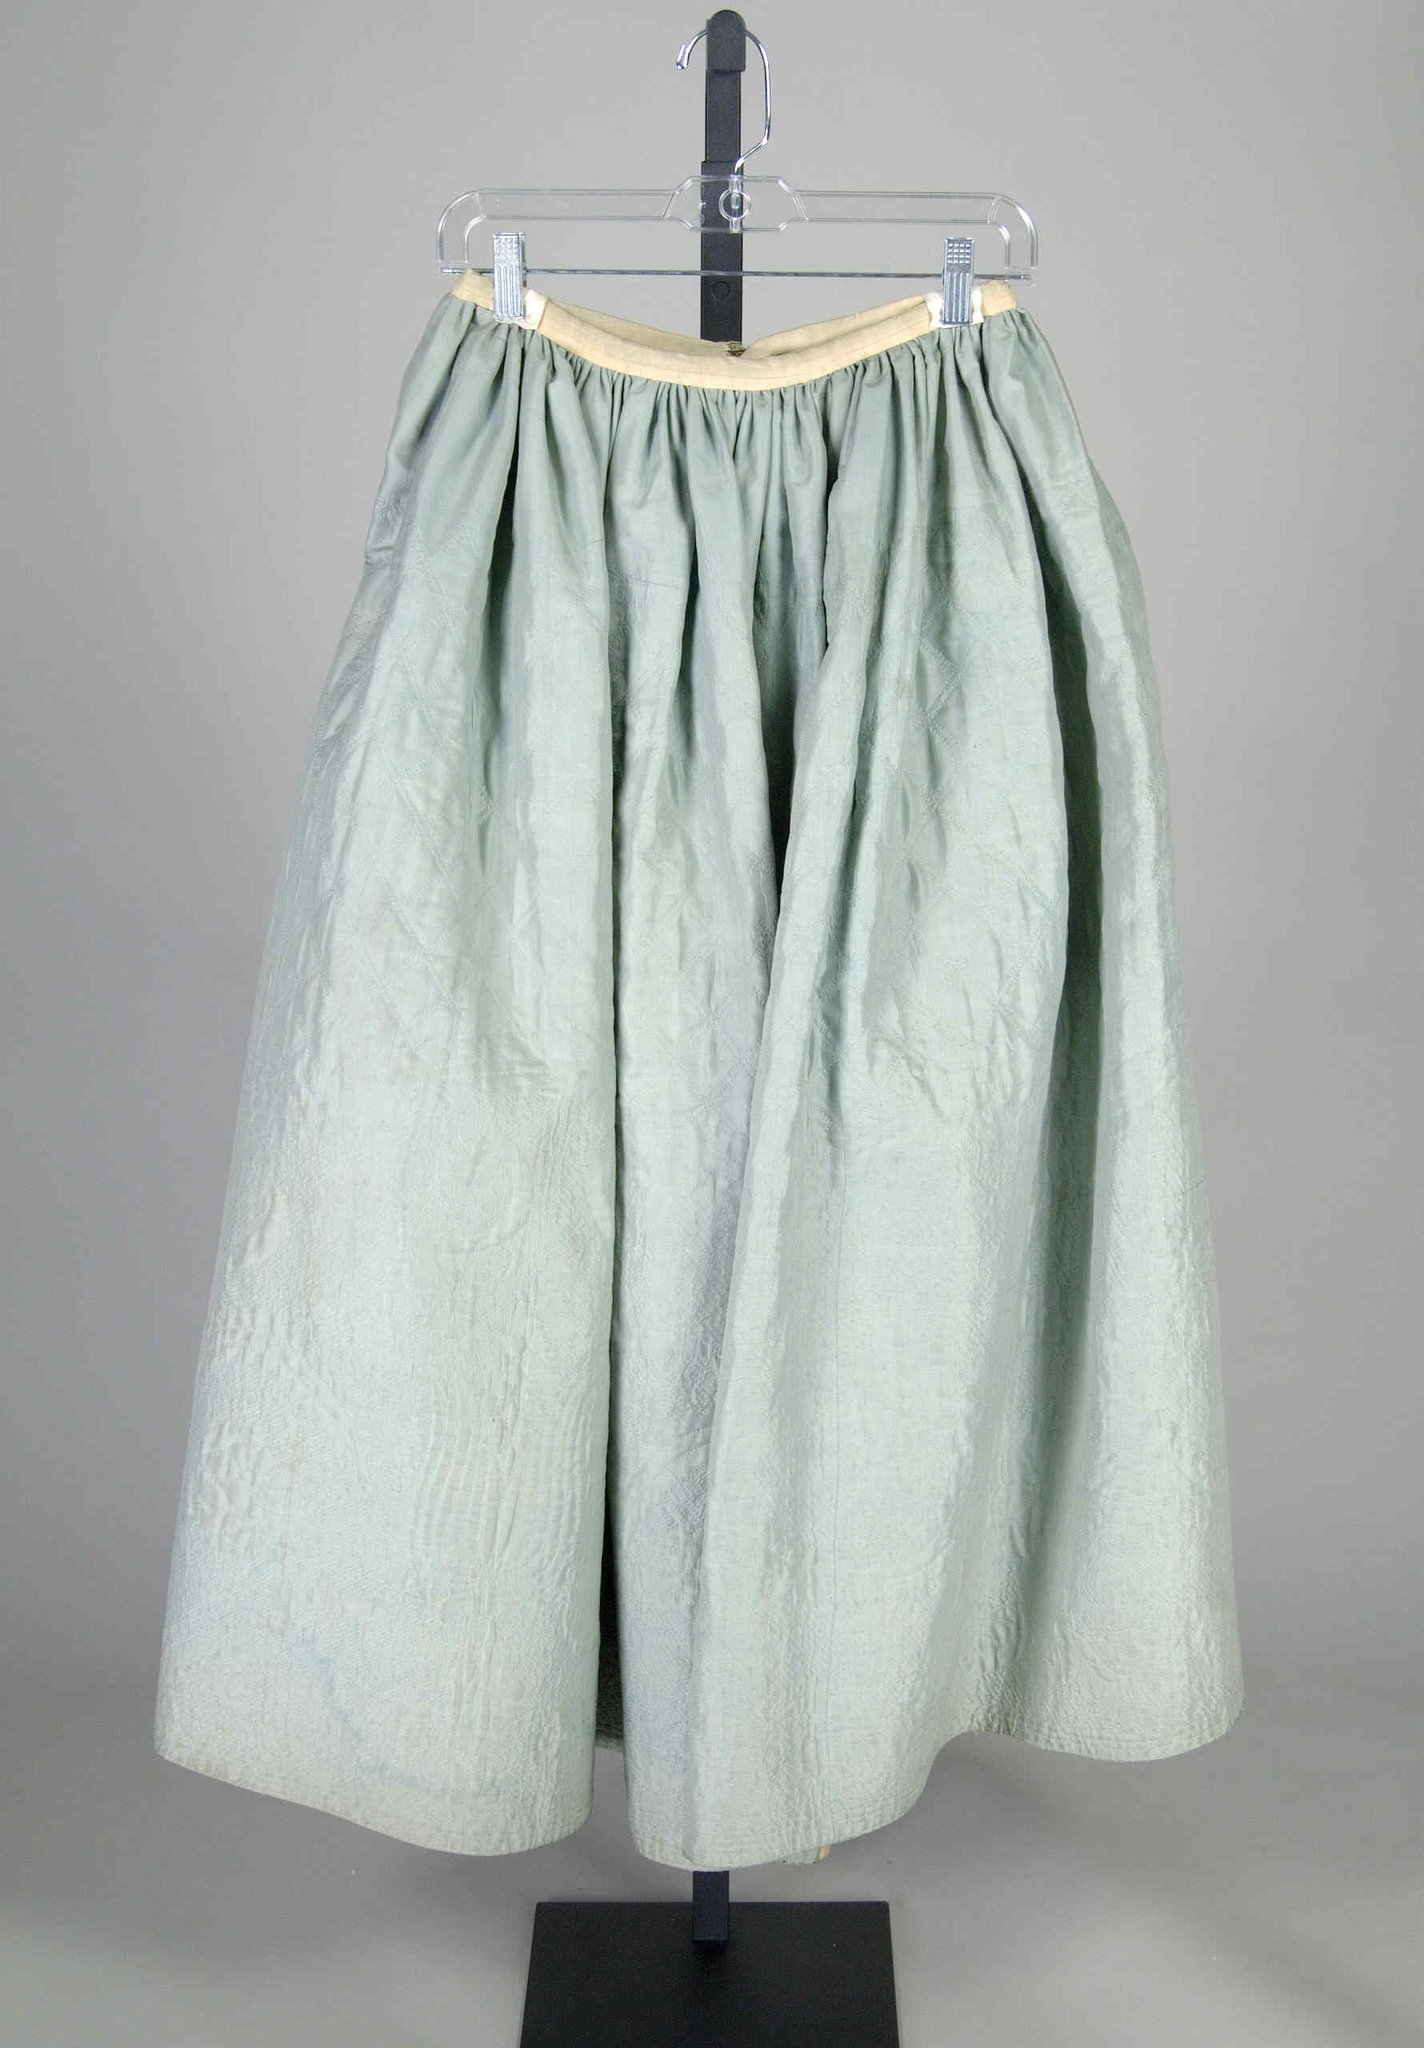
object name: petticoat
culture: american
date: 1776-1800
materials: cotton, silk